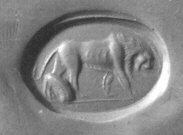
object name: stamp seal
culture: graeco-roman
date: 333-1 BCE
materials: jasper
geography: greece or italy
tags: lions